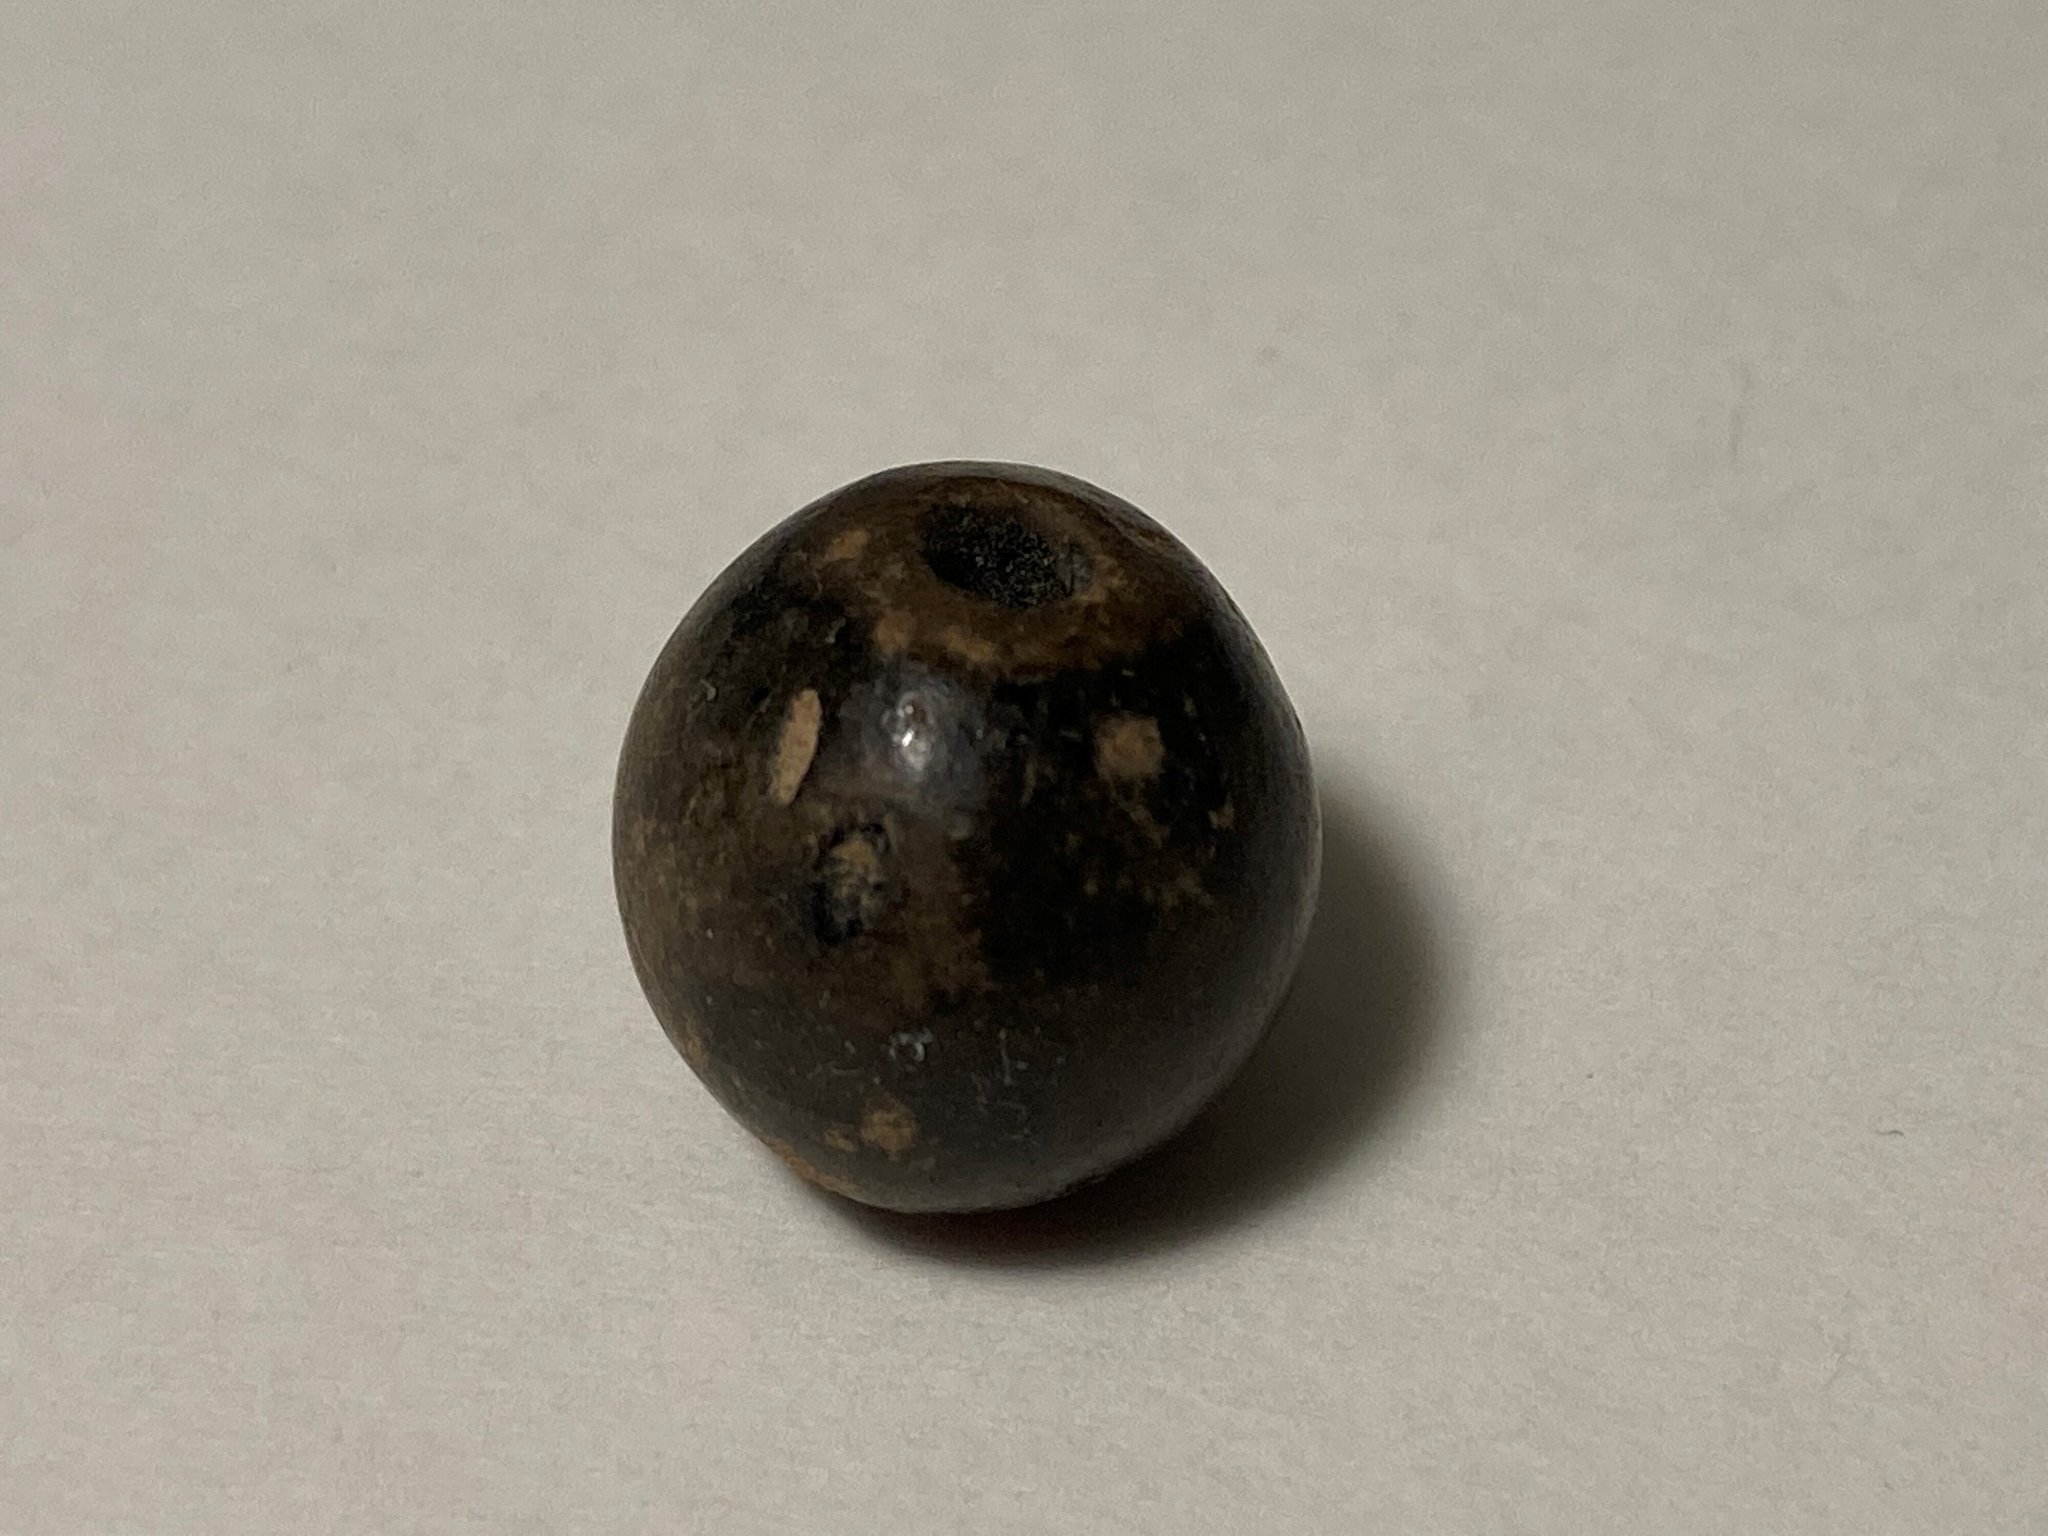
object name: bead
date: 701-1300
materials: wood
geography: iran